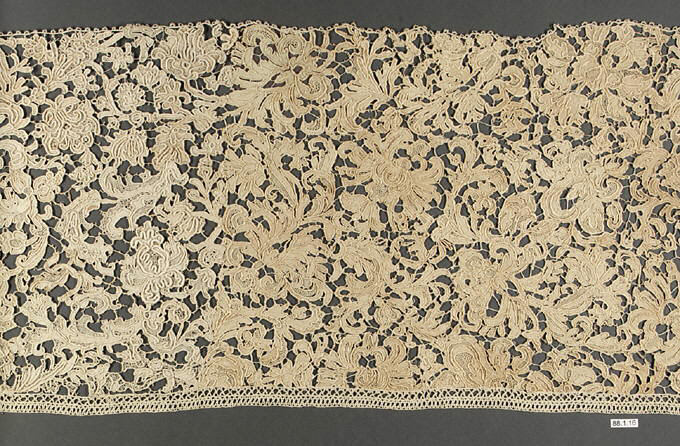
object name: border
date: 1601-1700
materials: lace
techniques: gros point, lace